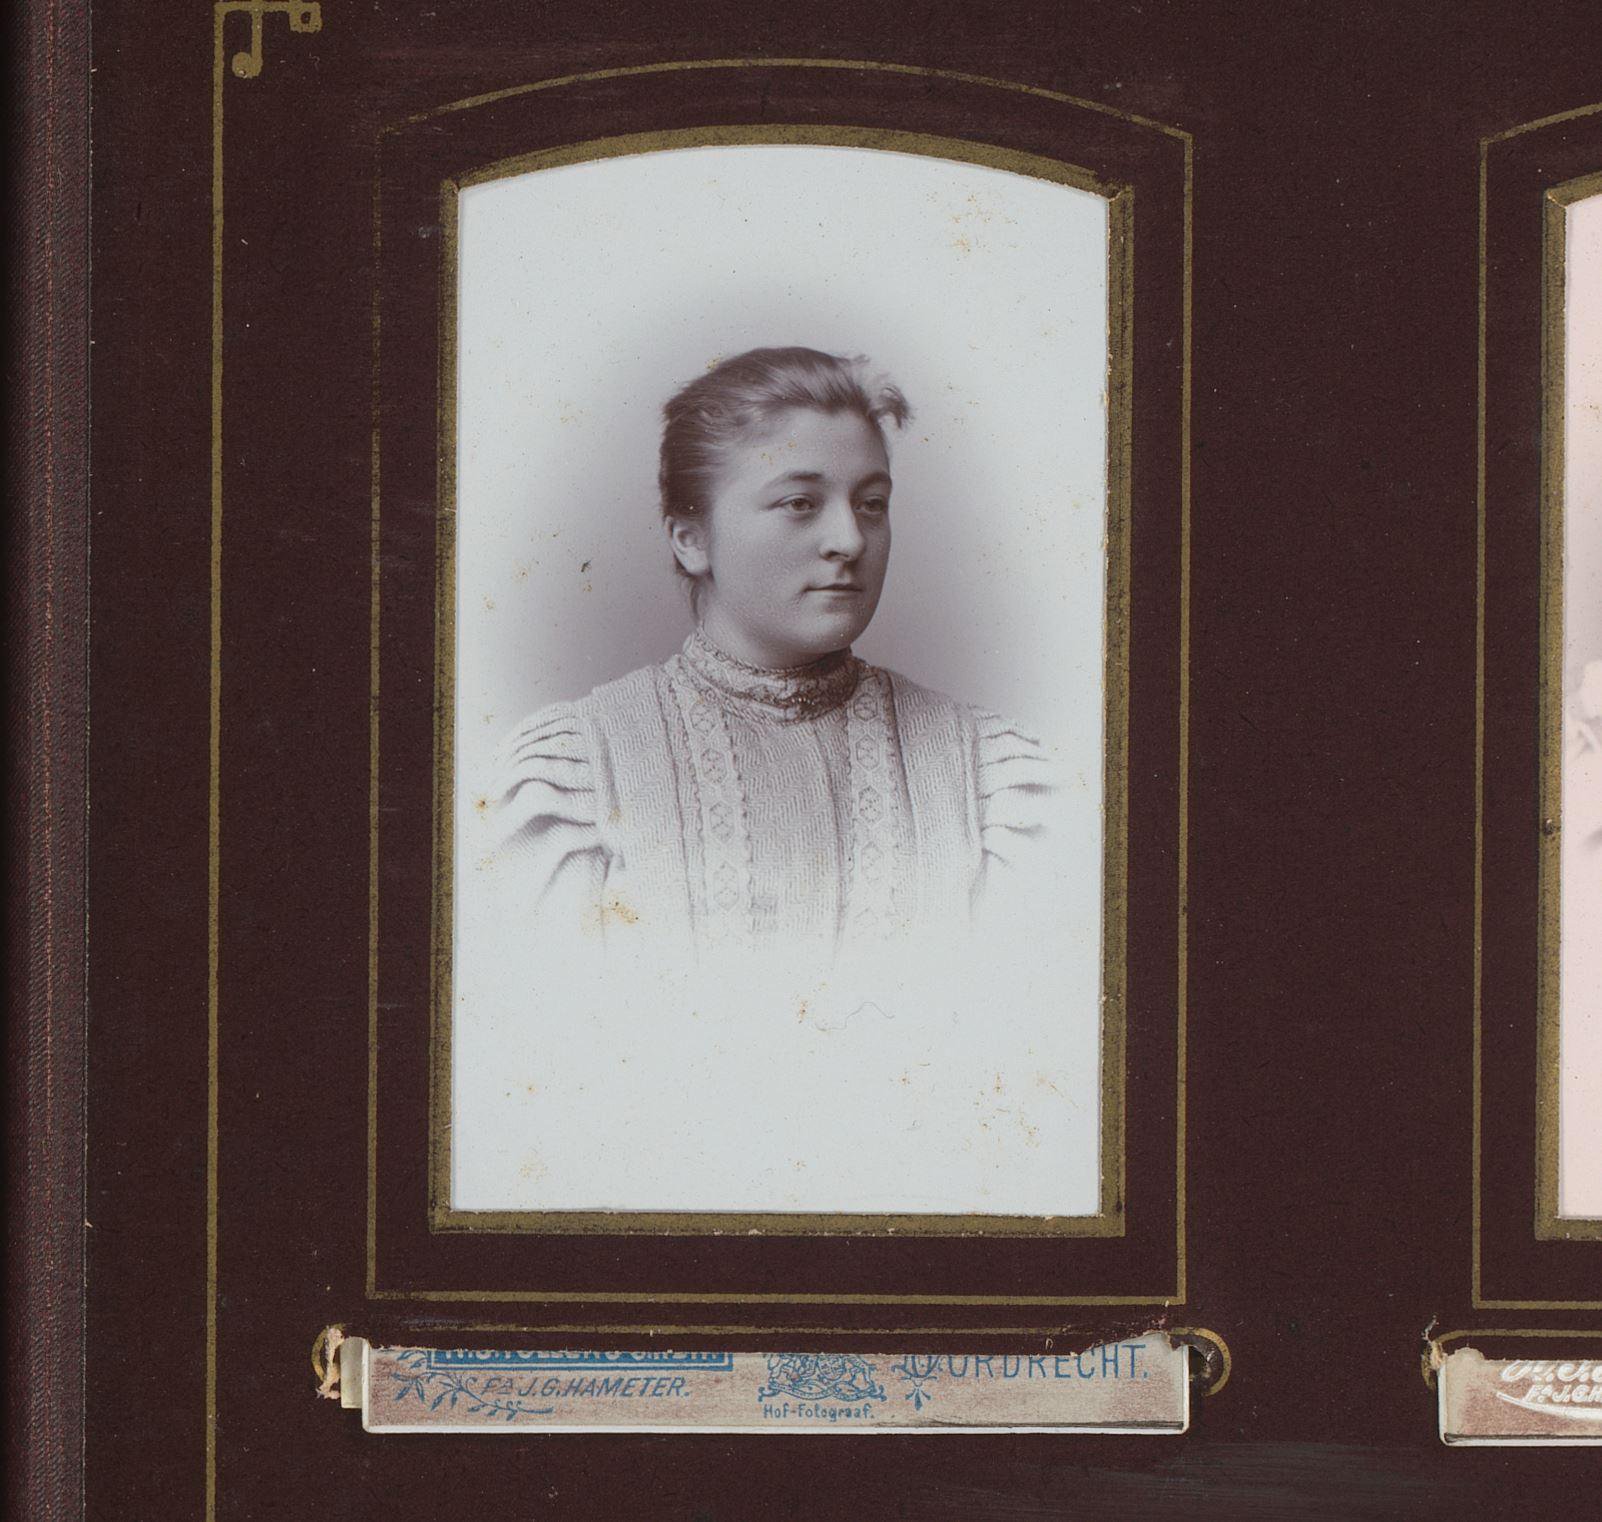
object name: album leaf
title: Portret van een jonge vrouw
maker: henricus jacobus tollens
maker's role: painter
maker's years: 1864-1936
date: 1891-1905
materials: cardboard, photographic support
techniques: collodion silver print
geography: dordrecht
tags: adolescent, young woman, maiden, historical persons - bb - woman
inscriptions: inscription: ‘Hof-Fotograaf/ van/ H. M. de Koningin/ der Nederlanden./ H.J. Tollens C. Hzn./ Dordrecht/ Voorstraat 289/ BEKROOND OP DE TENTOONSTELLING:/ TE UTRECHT 1876 - TE AMSTERDAM 1877 - THE ARNHEM 1879/ TE LEEUWARDEN 1881 - TE AMSTERDAM 1883/ LÜBECK 1888 - TE AMSTERDAM 1891.’